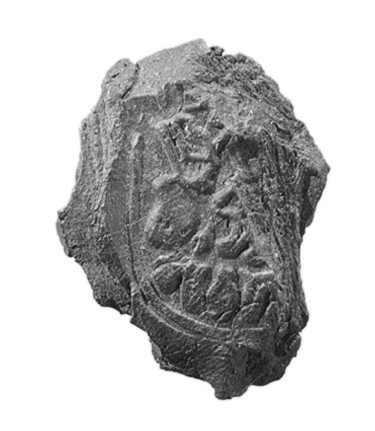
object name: sealing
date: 2030-1640 BCE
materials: clay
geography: egypt